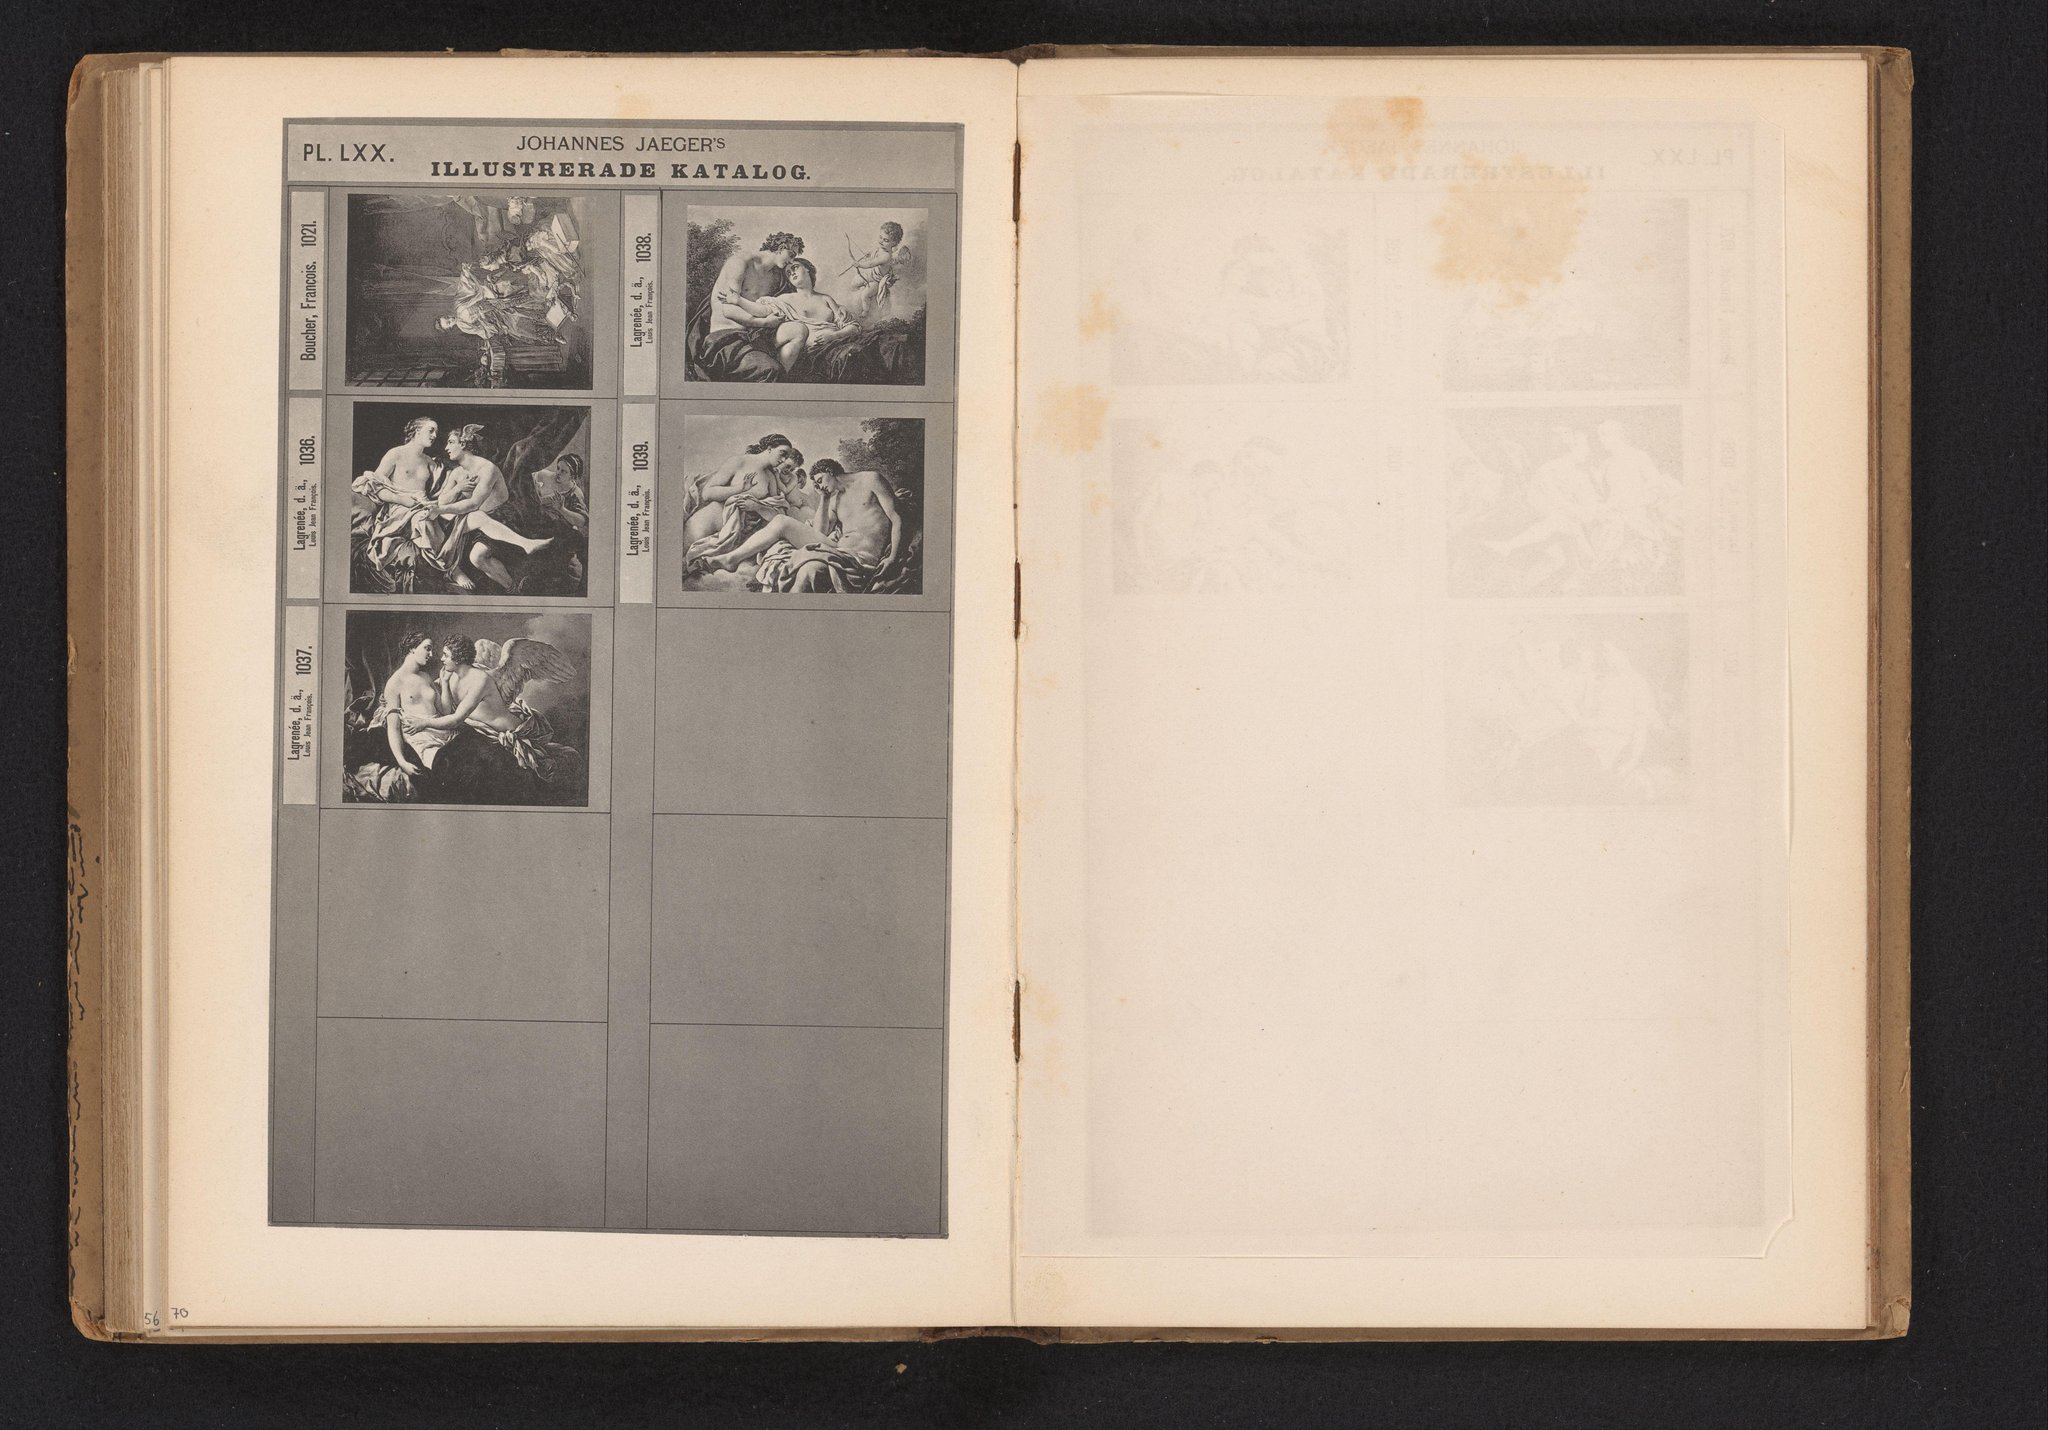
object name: reproduction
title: Fotoreproductie van vijf schilderijen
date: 1872-1882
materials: paper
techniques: photograph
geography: stockholm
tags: picture, painting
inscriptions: number: ‘PL. LXX.’